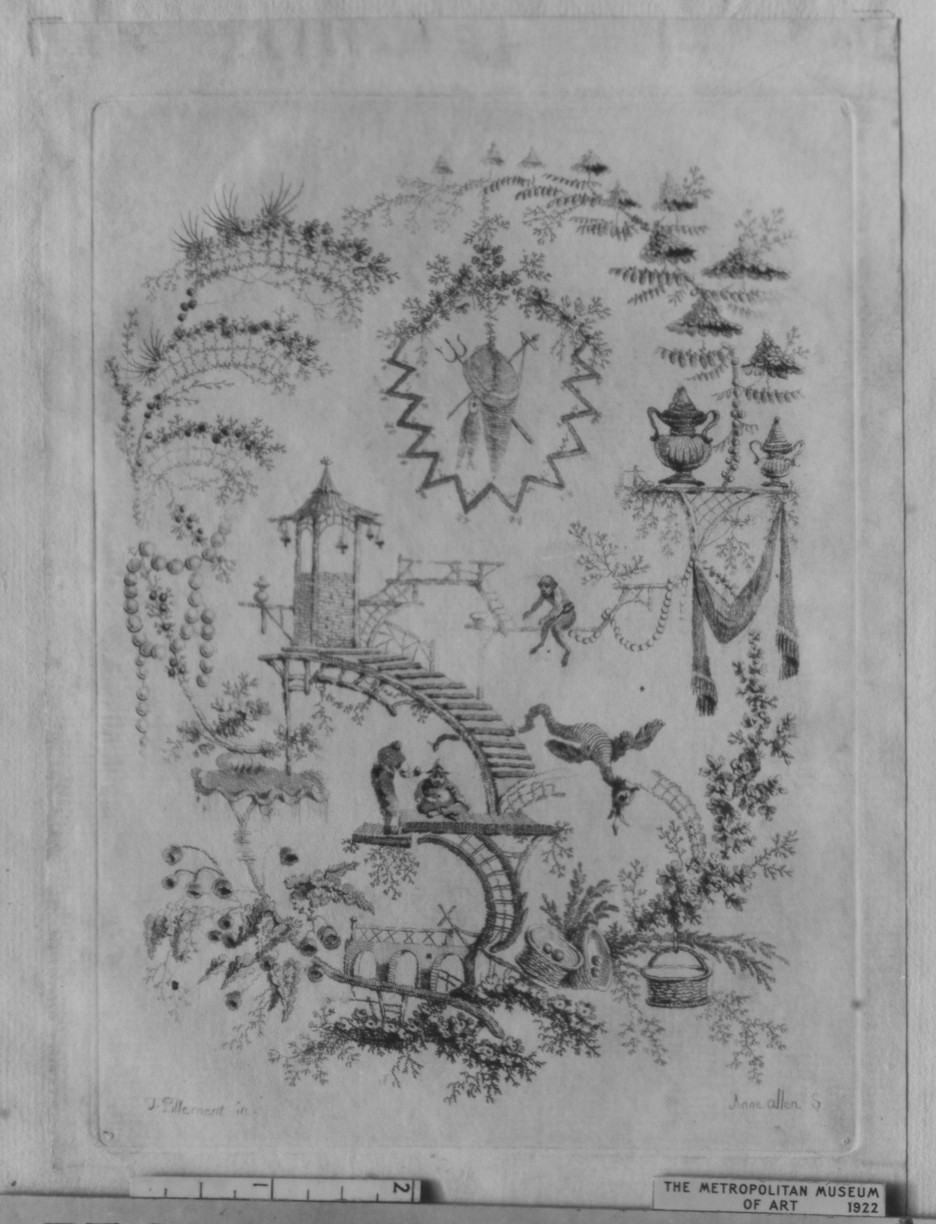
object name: print ornament architecture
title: Chinoiserie, from "Nouvelle Suite de Cahiers arabesques chinois a l'usage des dessinateurs et des peintres"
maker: jean pillement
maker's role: artist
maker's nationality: french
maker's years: 1728-1808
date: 1790-1799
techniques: etching, lithography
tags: human figures,birds,chinoiserie,flowers